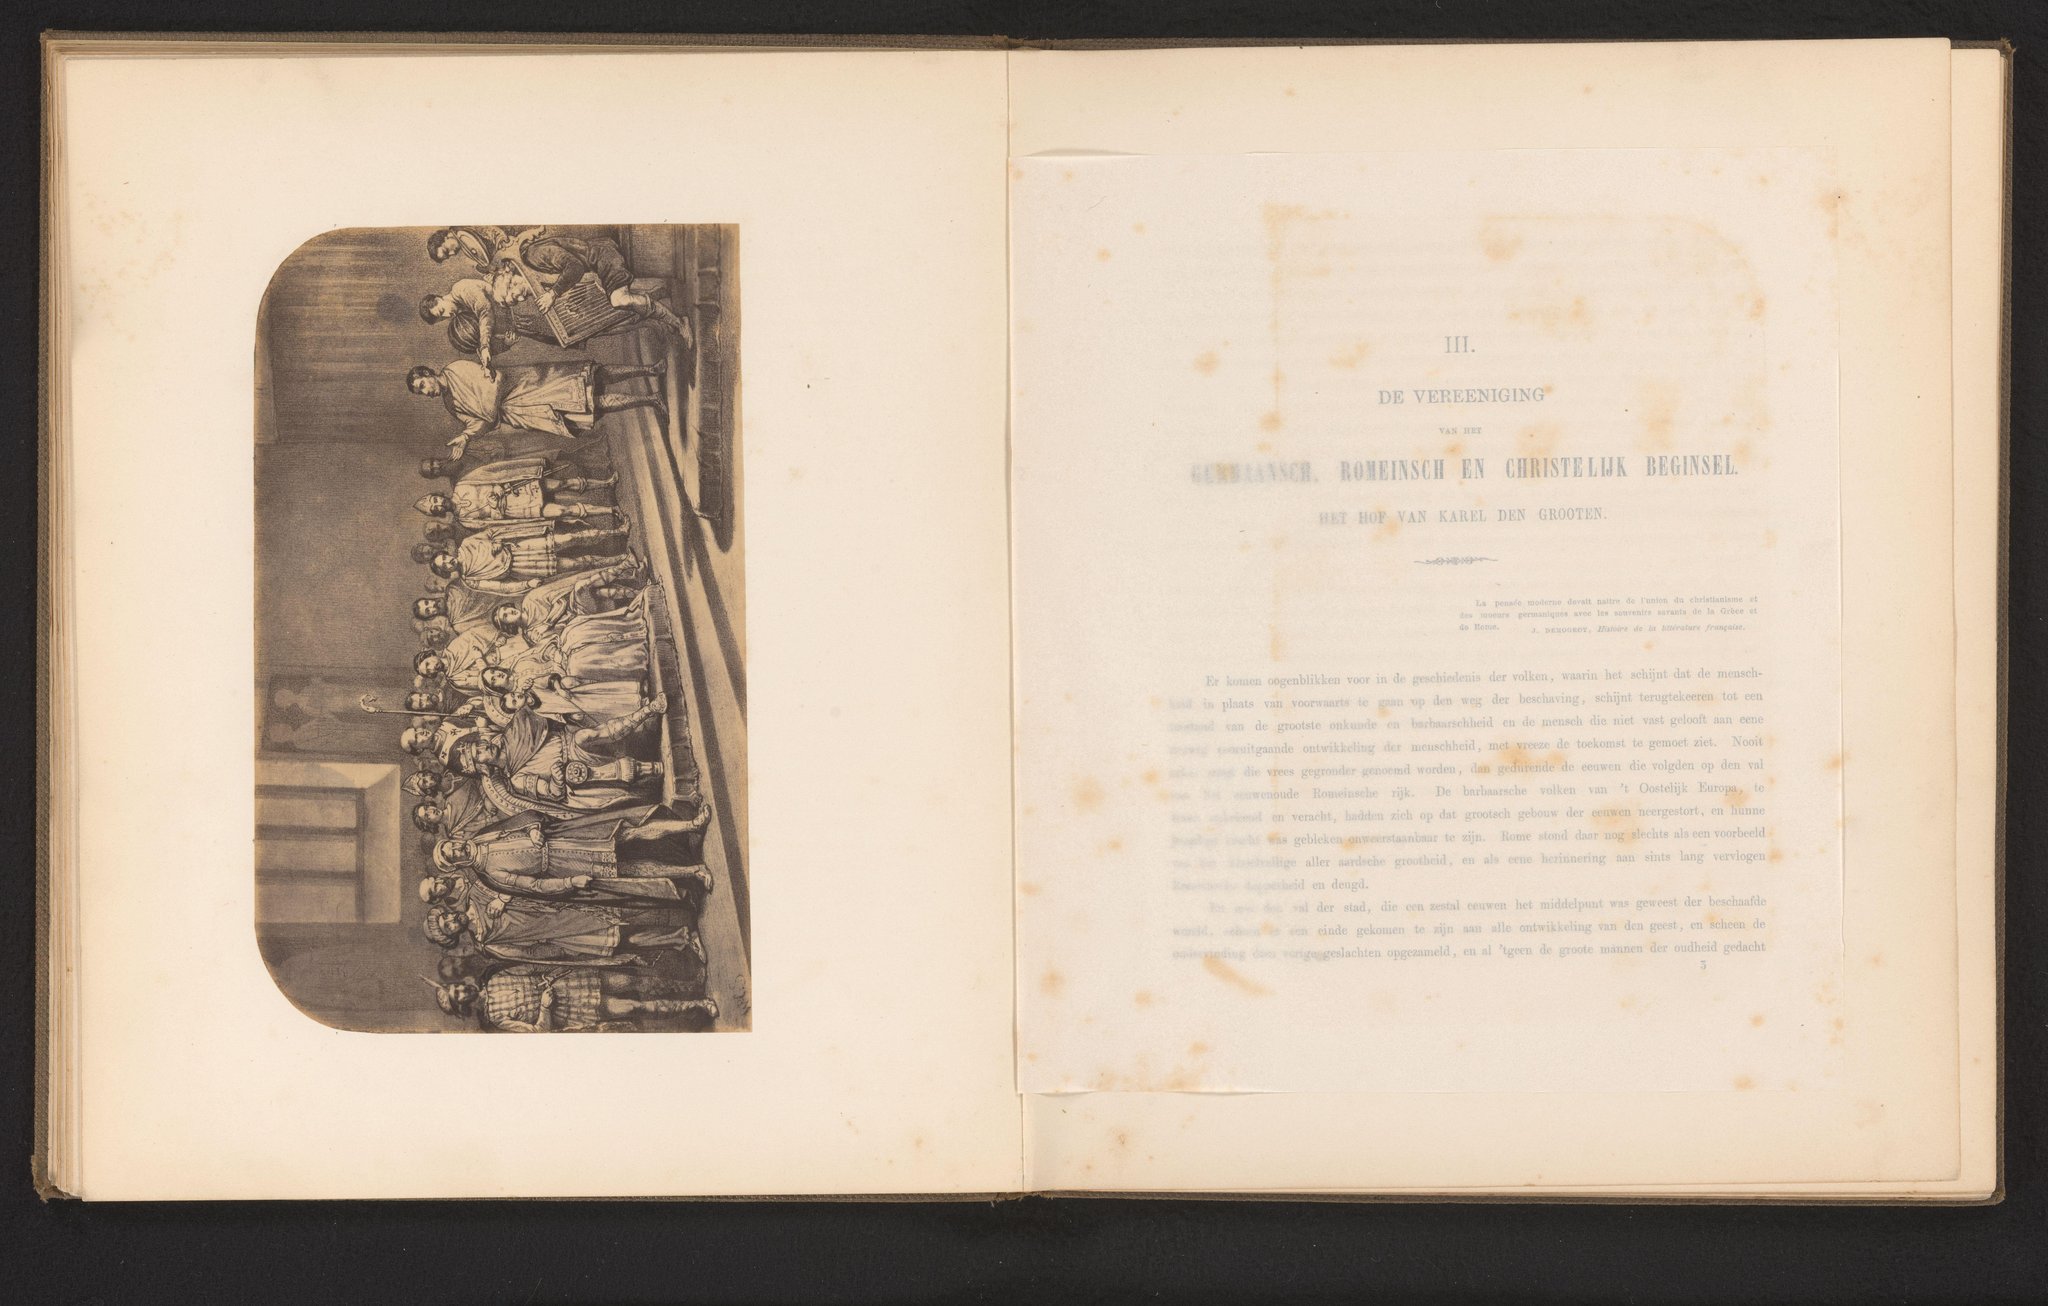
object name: reproduction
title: Fotoreproductie van een prent van een bijeenkomst aan het hof van Karel de Grote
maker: willem adrianus van hoek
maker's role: fotograaf, schrijver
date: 1856-1861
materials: paper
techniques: albumen print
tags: charlemagne (holy roman emperor), family of a ruler, and court, emperor